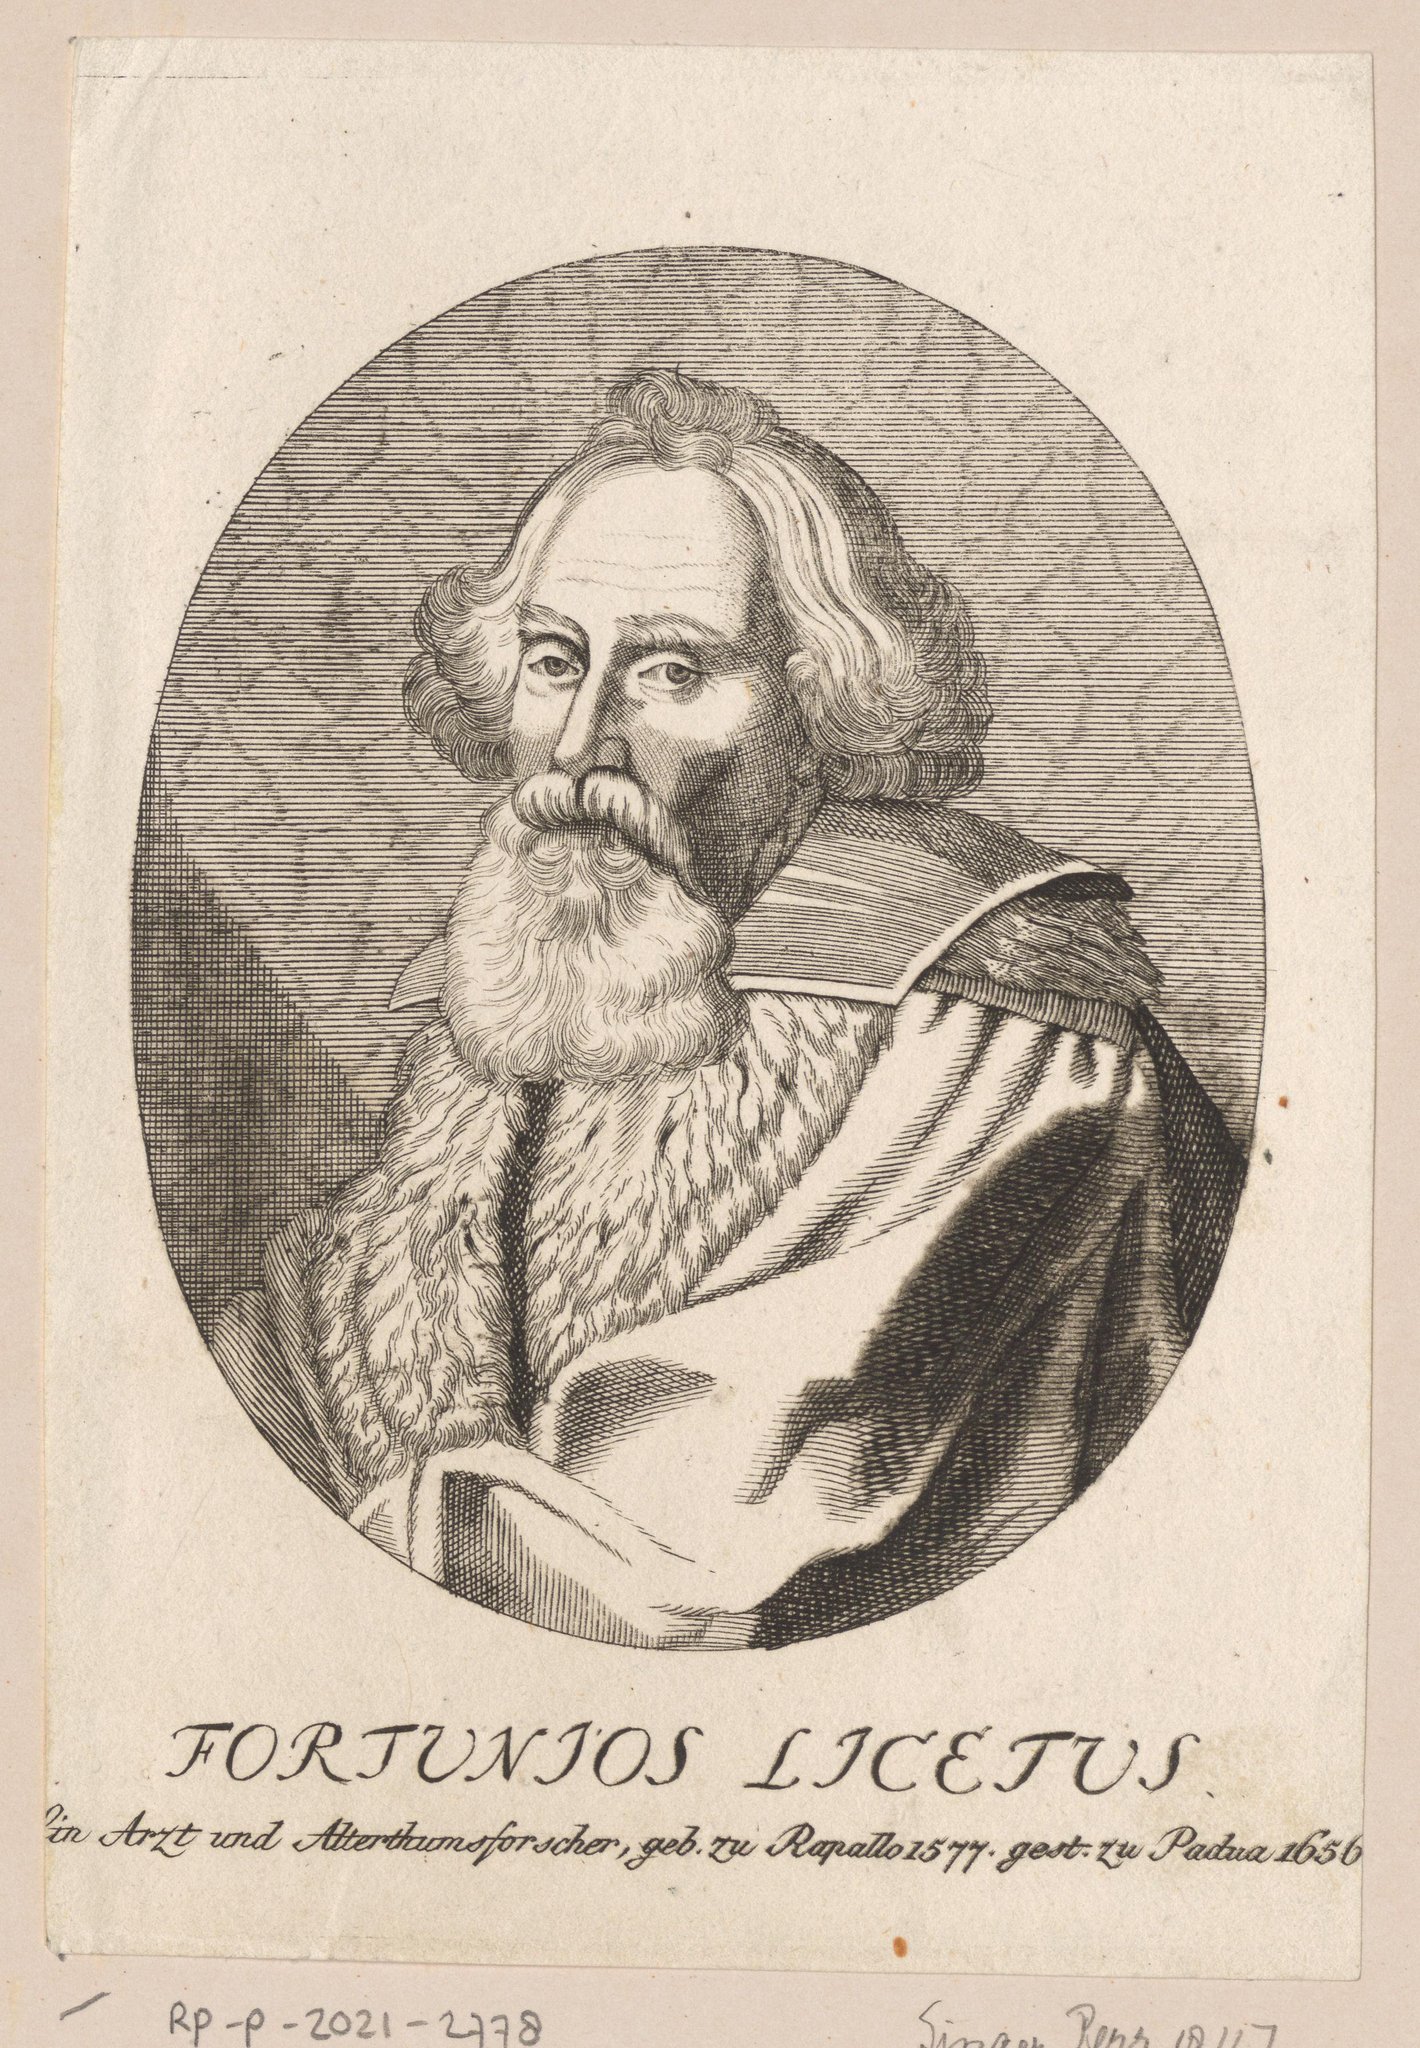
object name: print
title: Portret van Fortunio Liceti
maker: Anonymous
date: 1750-1850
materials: paper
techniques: engraving, etching, intaglio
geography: germany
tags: historical persons, physician, doctor (+ portrait of scholar, scientist)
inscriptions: number: ‘3297’